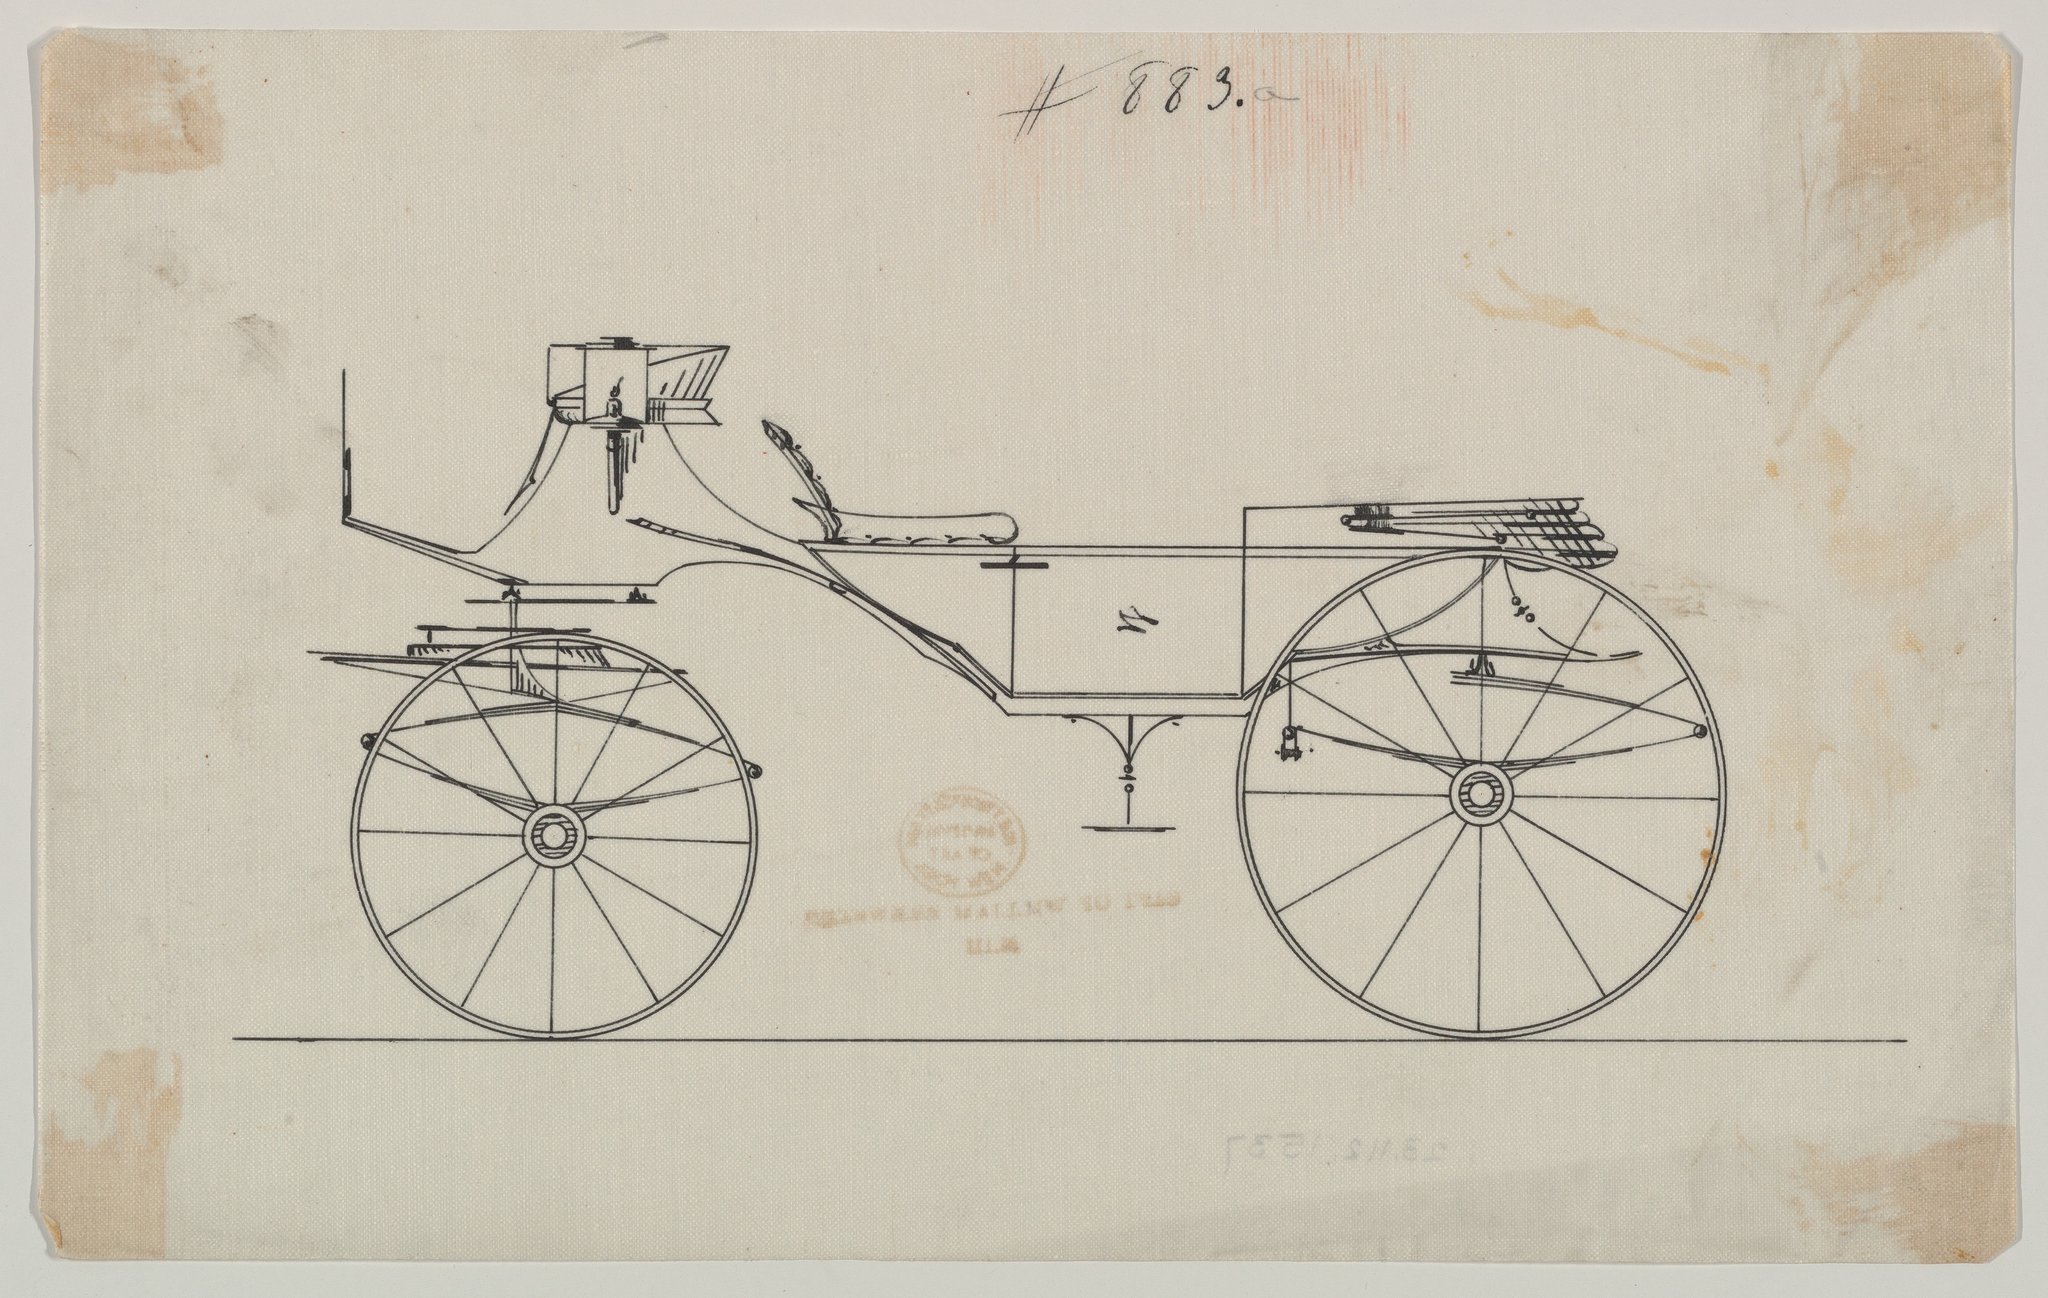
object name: drawing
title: Design for Vis-à-vis, no. 883a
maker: brewster & co.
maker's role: manufacturer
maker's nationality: american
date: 1850-1870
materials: ink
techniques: pen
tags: carriages